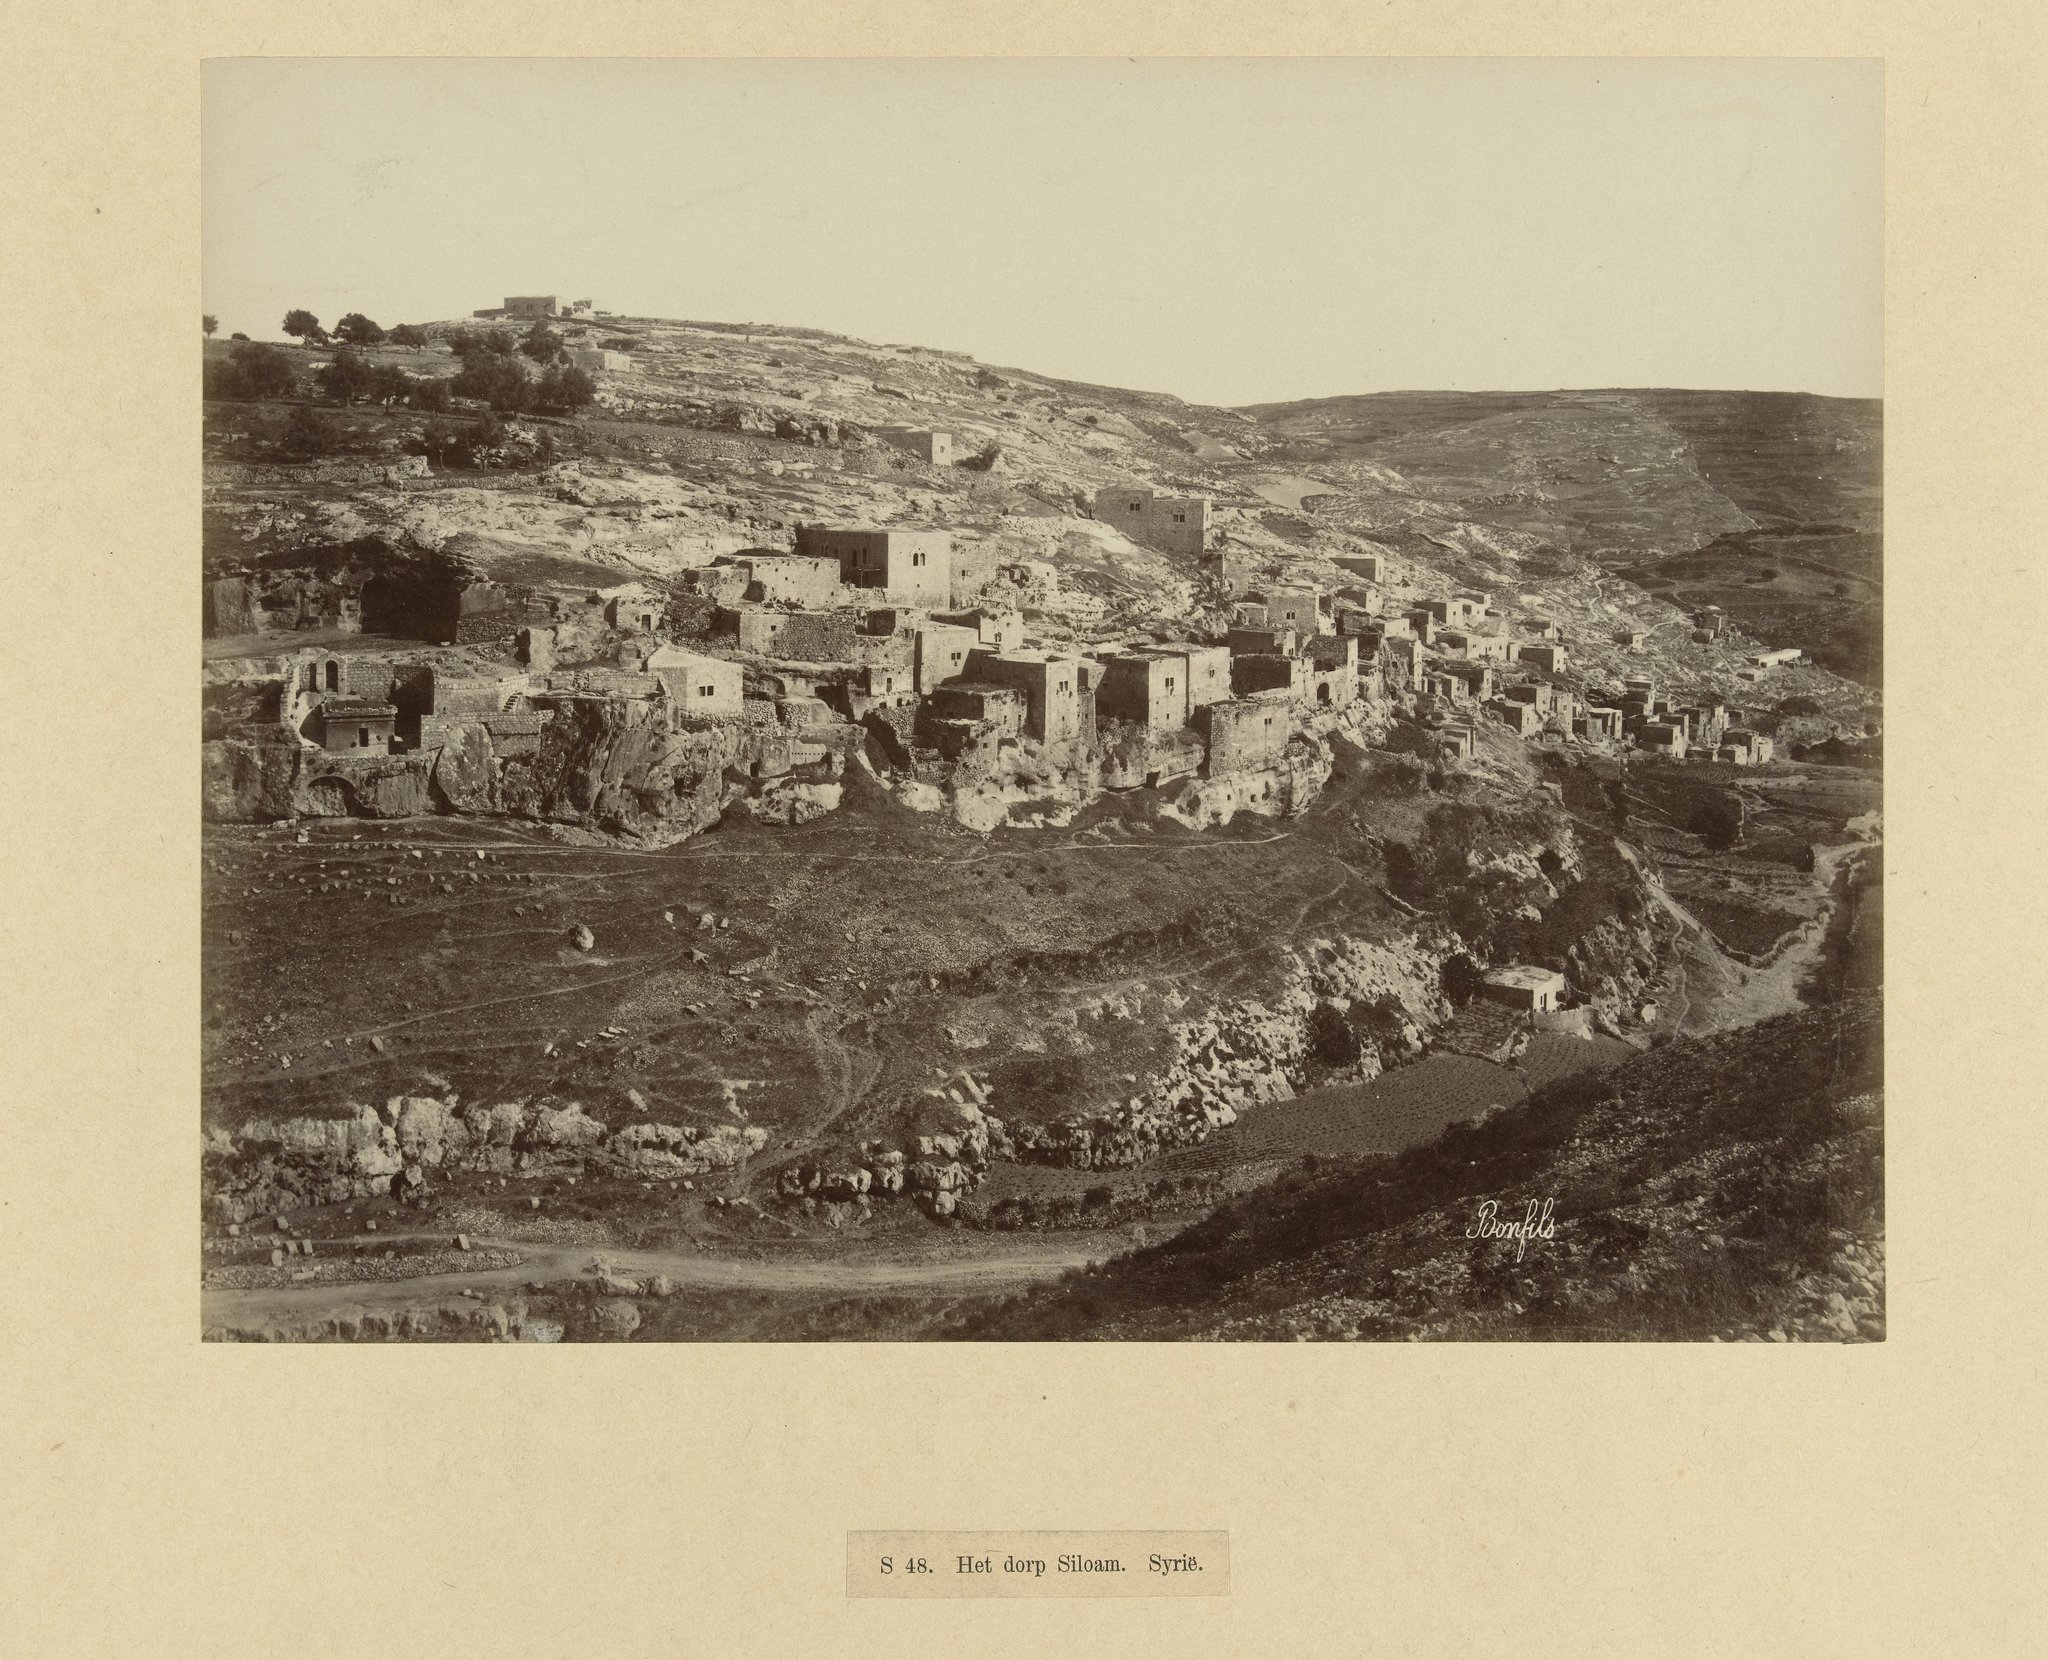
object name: photograph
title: S 48. Het dorp Siloam. Syrië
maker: félix bonfils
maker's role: fotograaf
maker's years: 1831-1885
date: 1867-1877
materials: cardboard, paper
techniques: albumen print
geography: jerusalem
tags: prospect of village, silhouette of village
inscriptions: check stamp: ‘Bristol/ L.M’, title: ‘S 48. Het dorp Siloam. Syrië.’, stamp: ‘Gemeentelijke bibliotheek/ Rotterdam’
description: Onderdeel van een groep door fotograaf Richard Polak op reis verzamelde foto’s. Deze foto is samen met andere op zijn reizen verzamelde foto's tentoongesteld bij de Rotterdamsche Kunstkring (1895), Arti en Amicitiae te Amsterdam (1897-1898?) en Societeit 't Collegie te Kampen (datum vooralsnog onbekend).